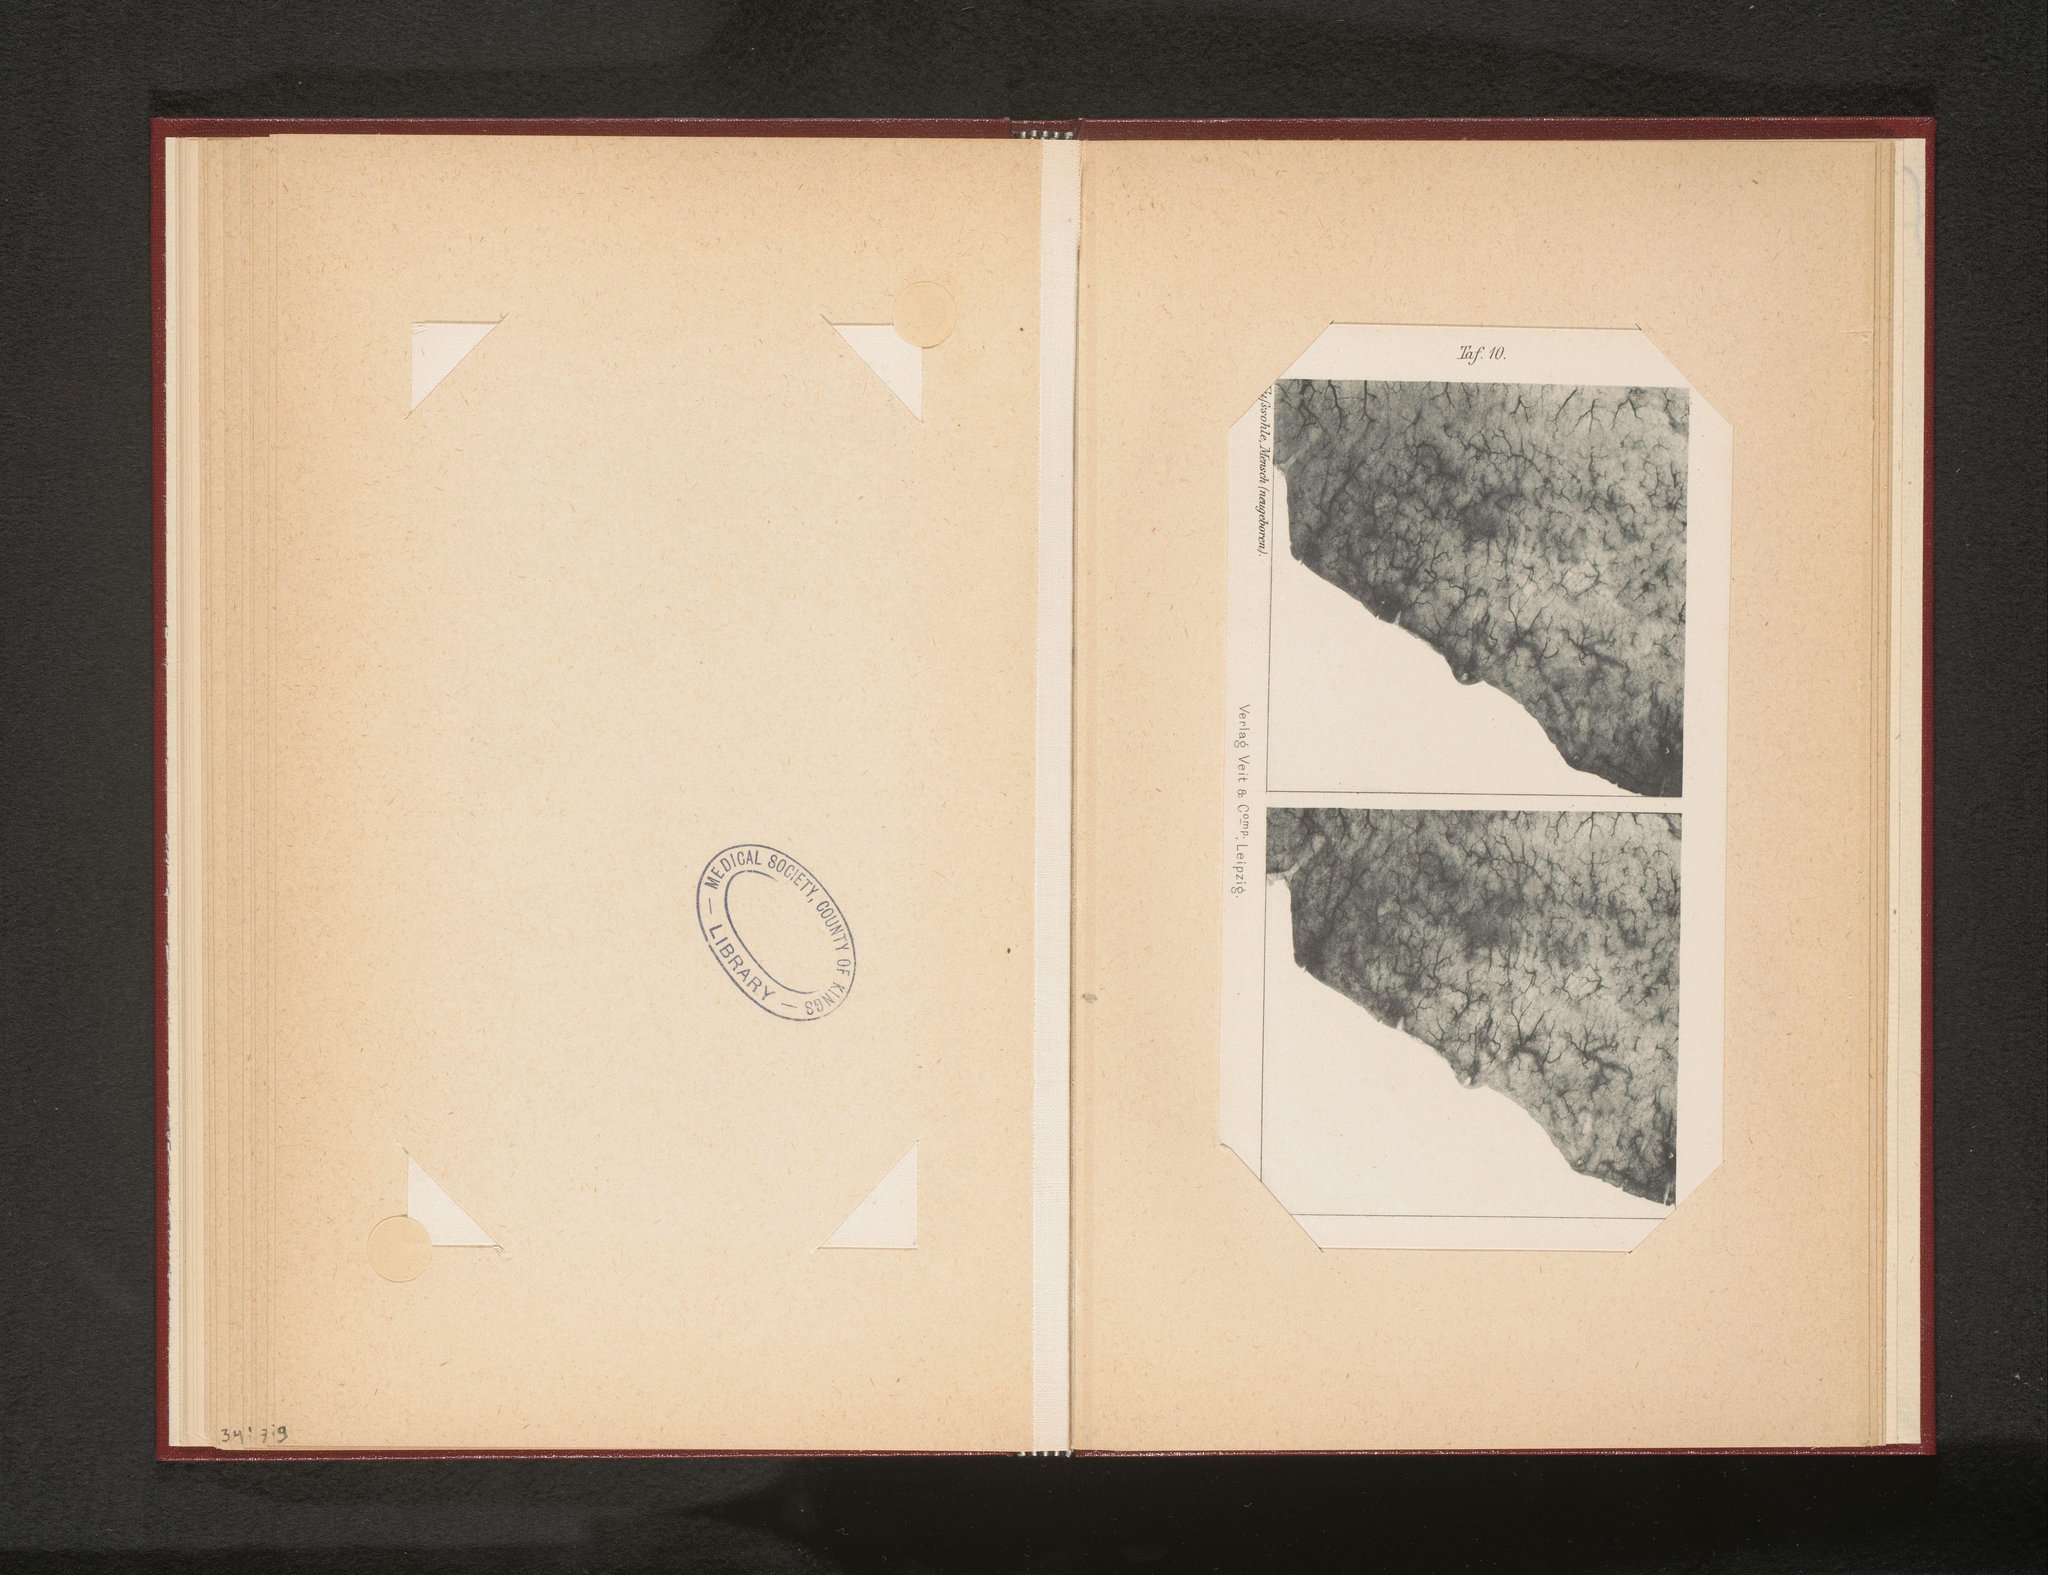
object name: page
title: Fusssohle, Mensch (neugeboren)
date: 1885-1895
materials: paper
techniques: photoaquatint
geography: leipzig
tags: skin (human)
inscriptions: number: ‘Taf. 10.’